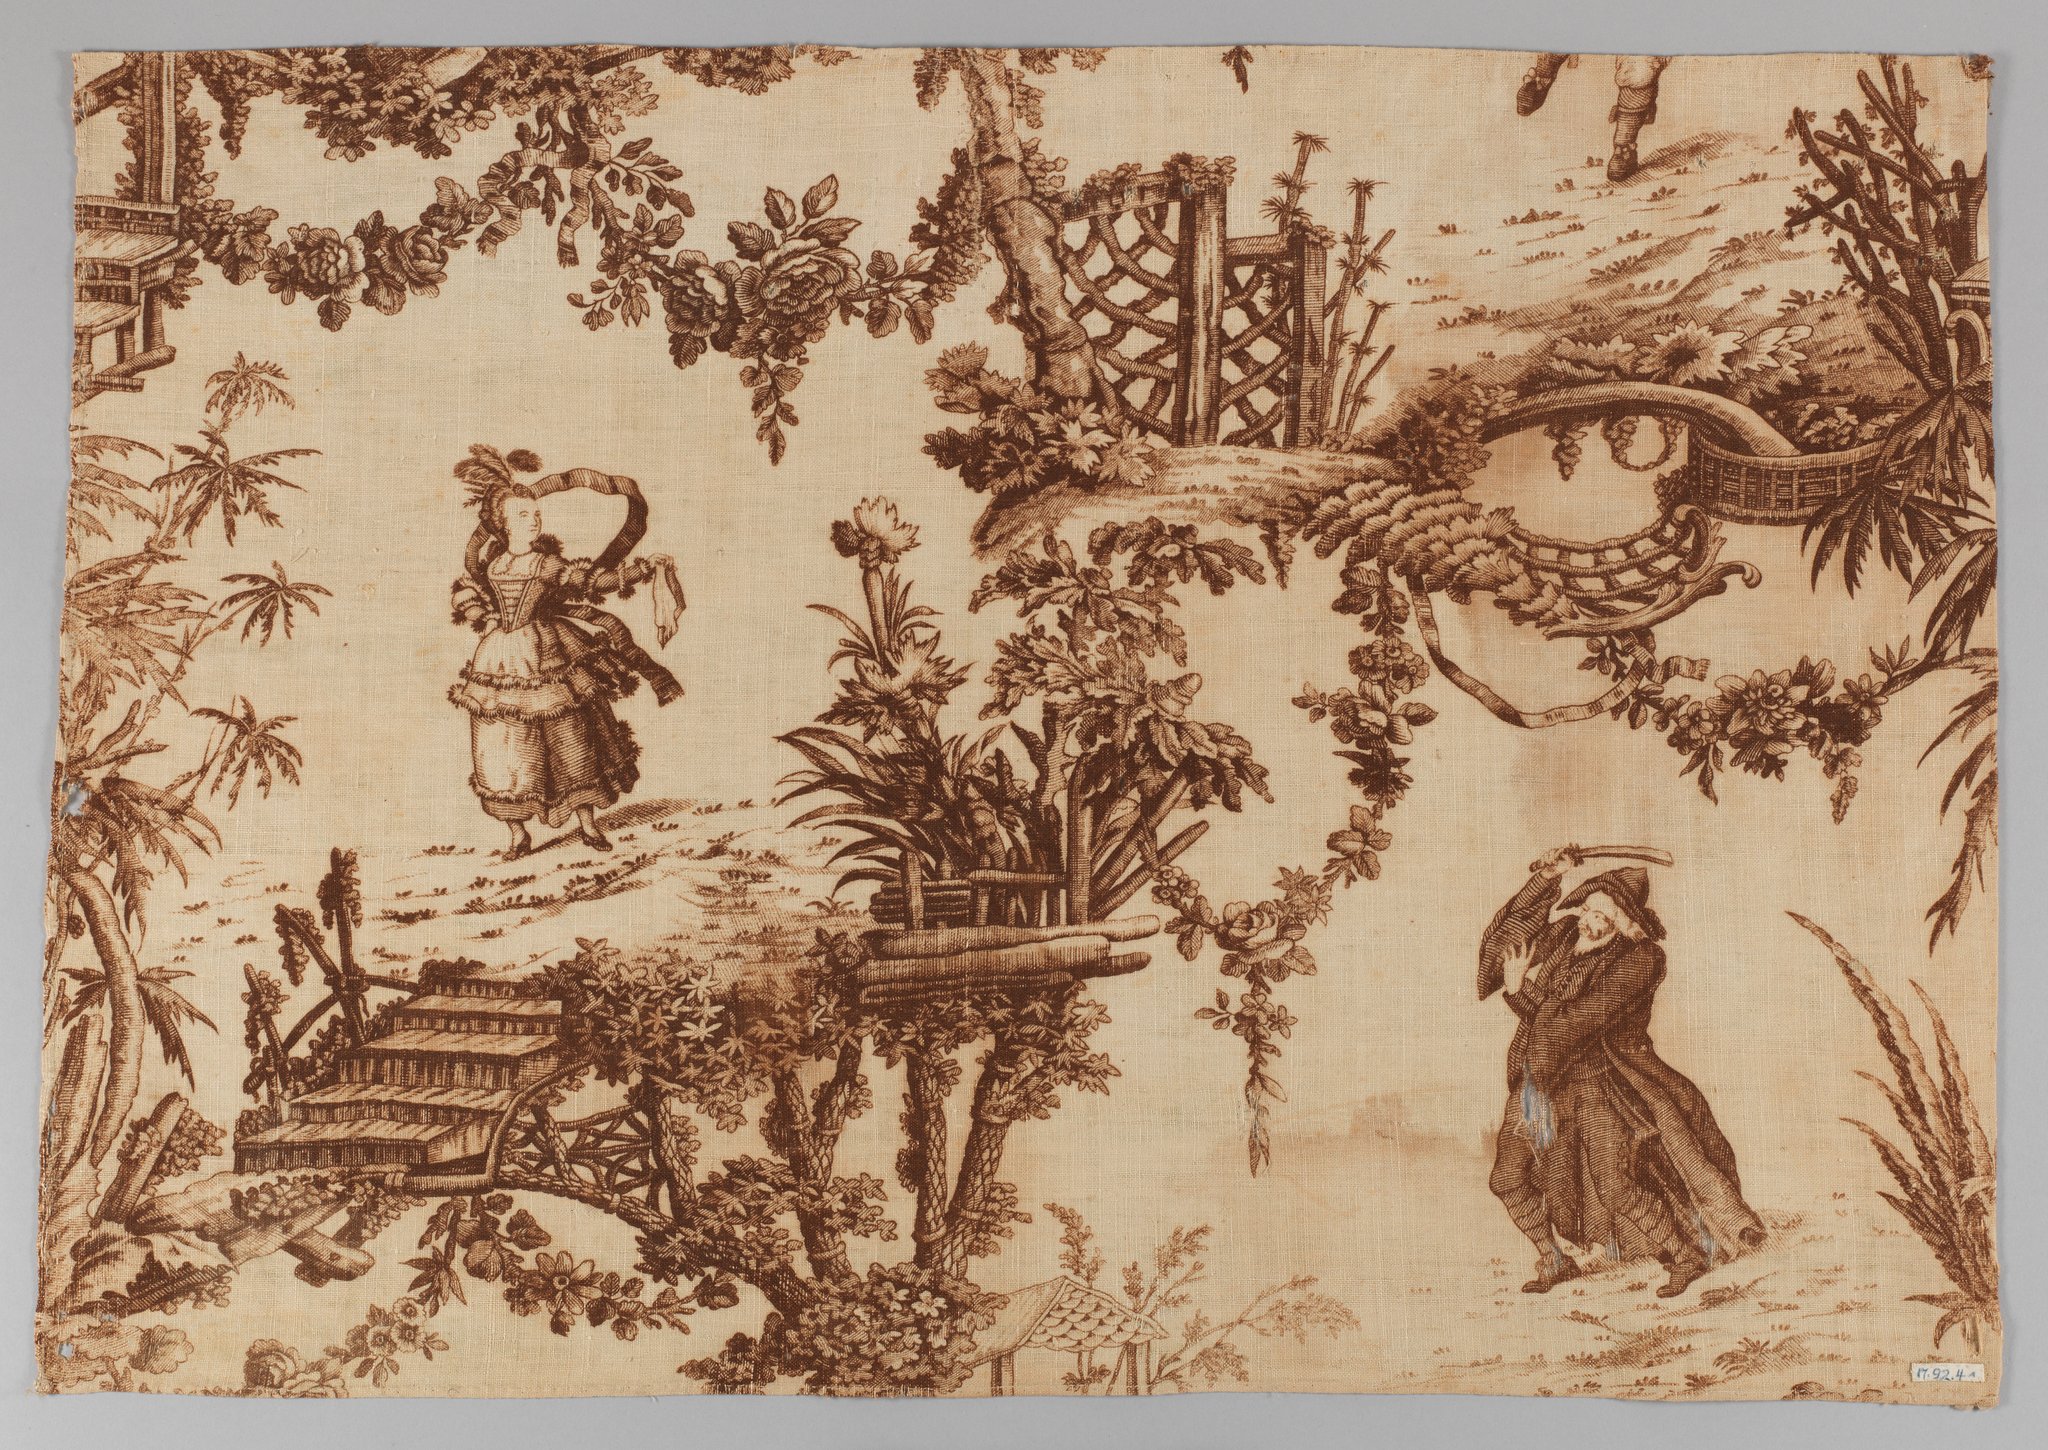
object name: furnishing textile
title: Pictorial print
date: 1701-1800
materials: cotton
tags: men,women